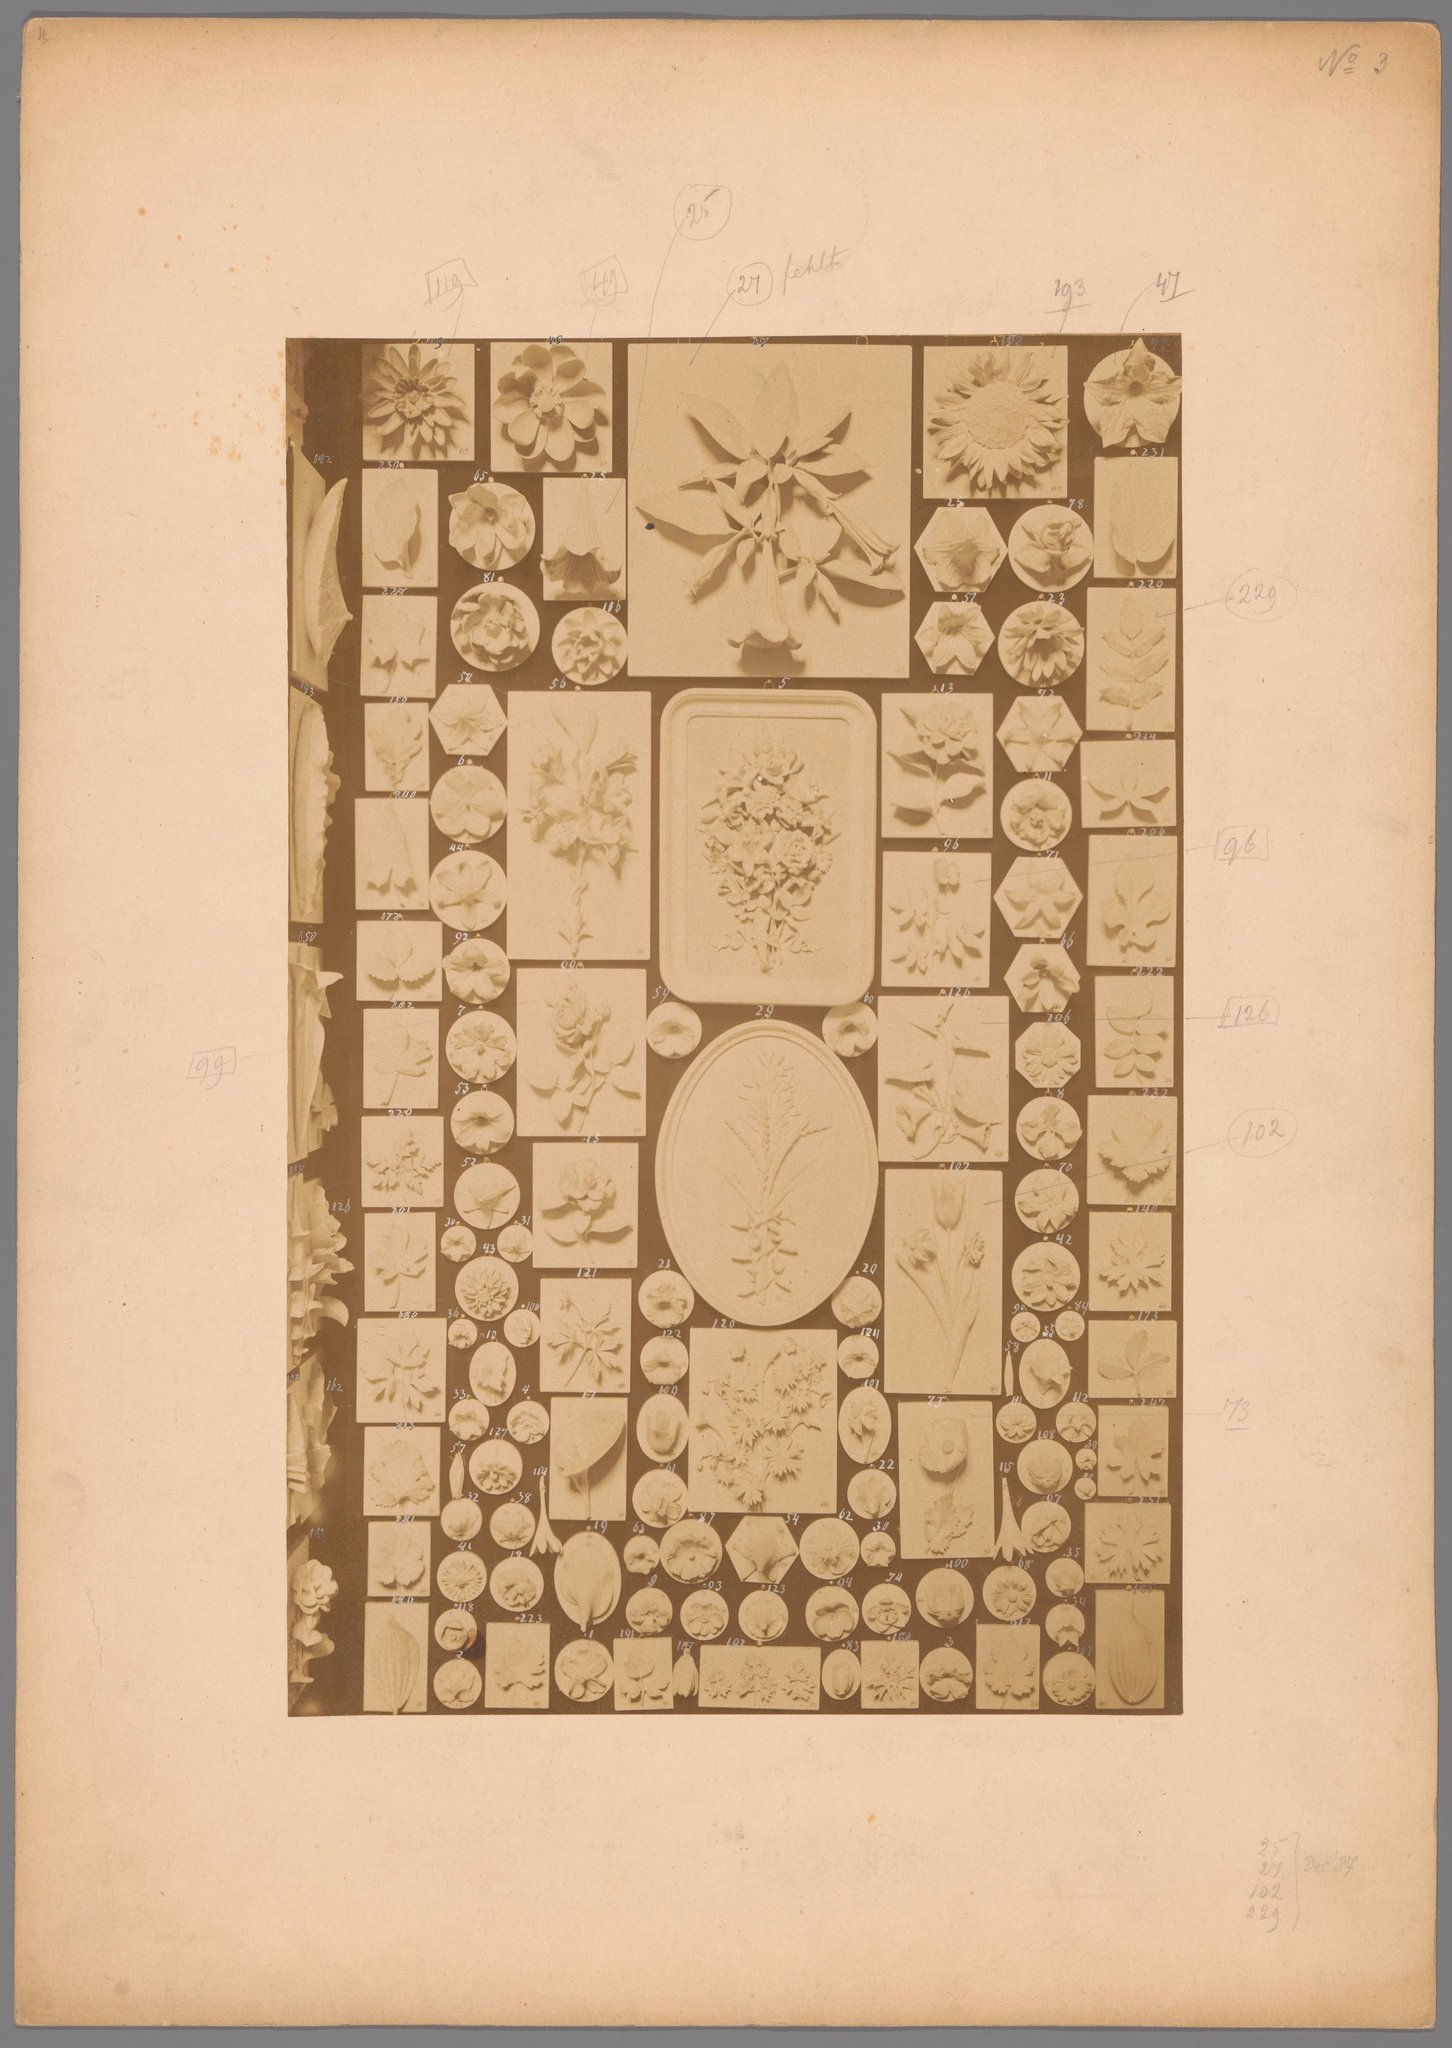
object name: photograph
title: Deel van een opstelling van pleistermodellen door J.G. Bofinger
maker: Anonymous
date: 1887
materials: cardboard, photographic support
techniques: albumen print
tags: ornaments ~ art, piece of sculpture, reproduction of a piece of sculpture, ornament derived from plant forms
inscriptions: number